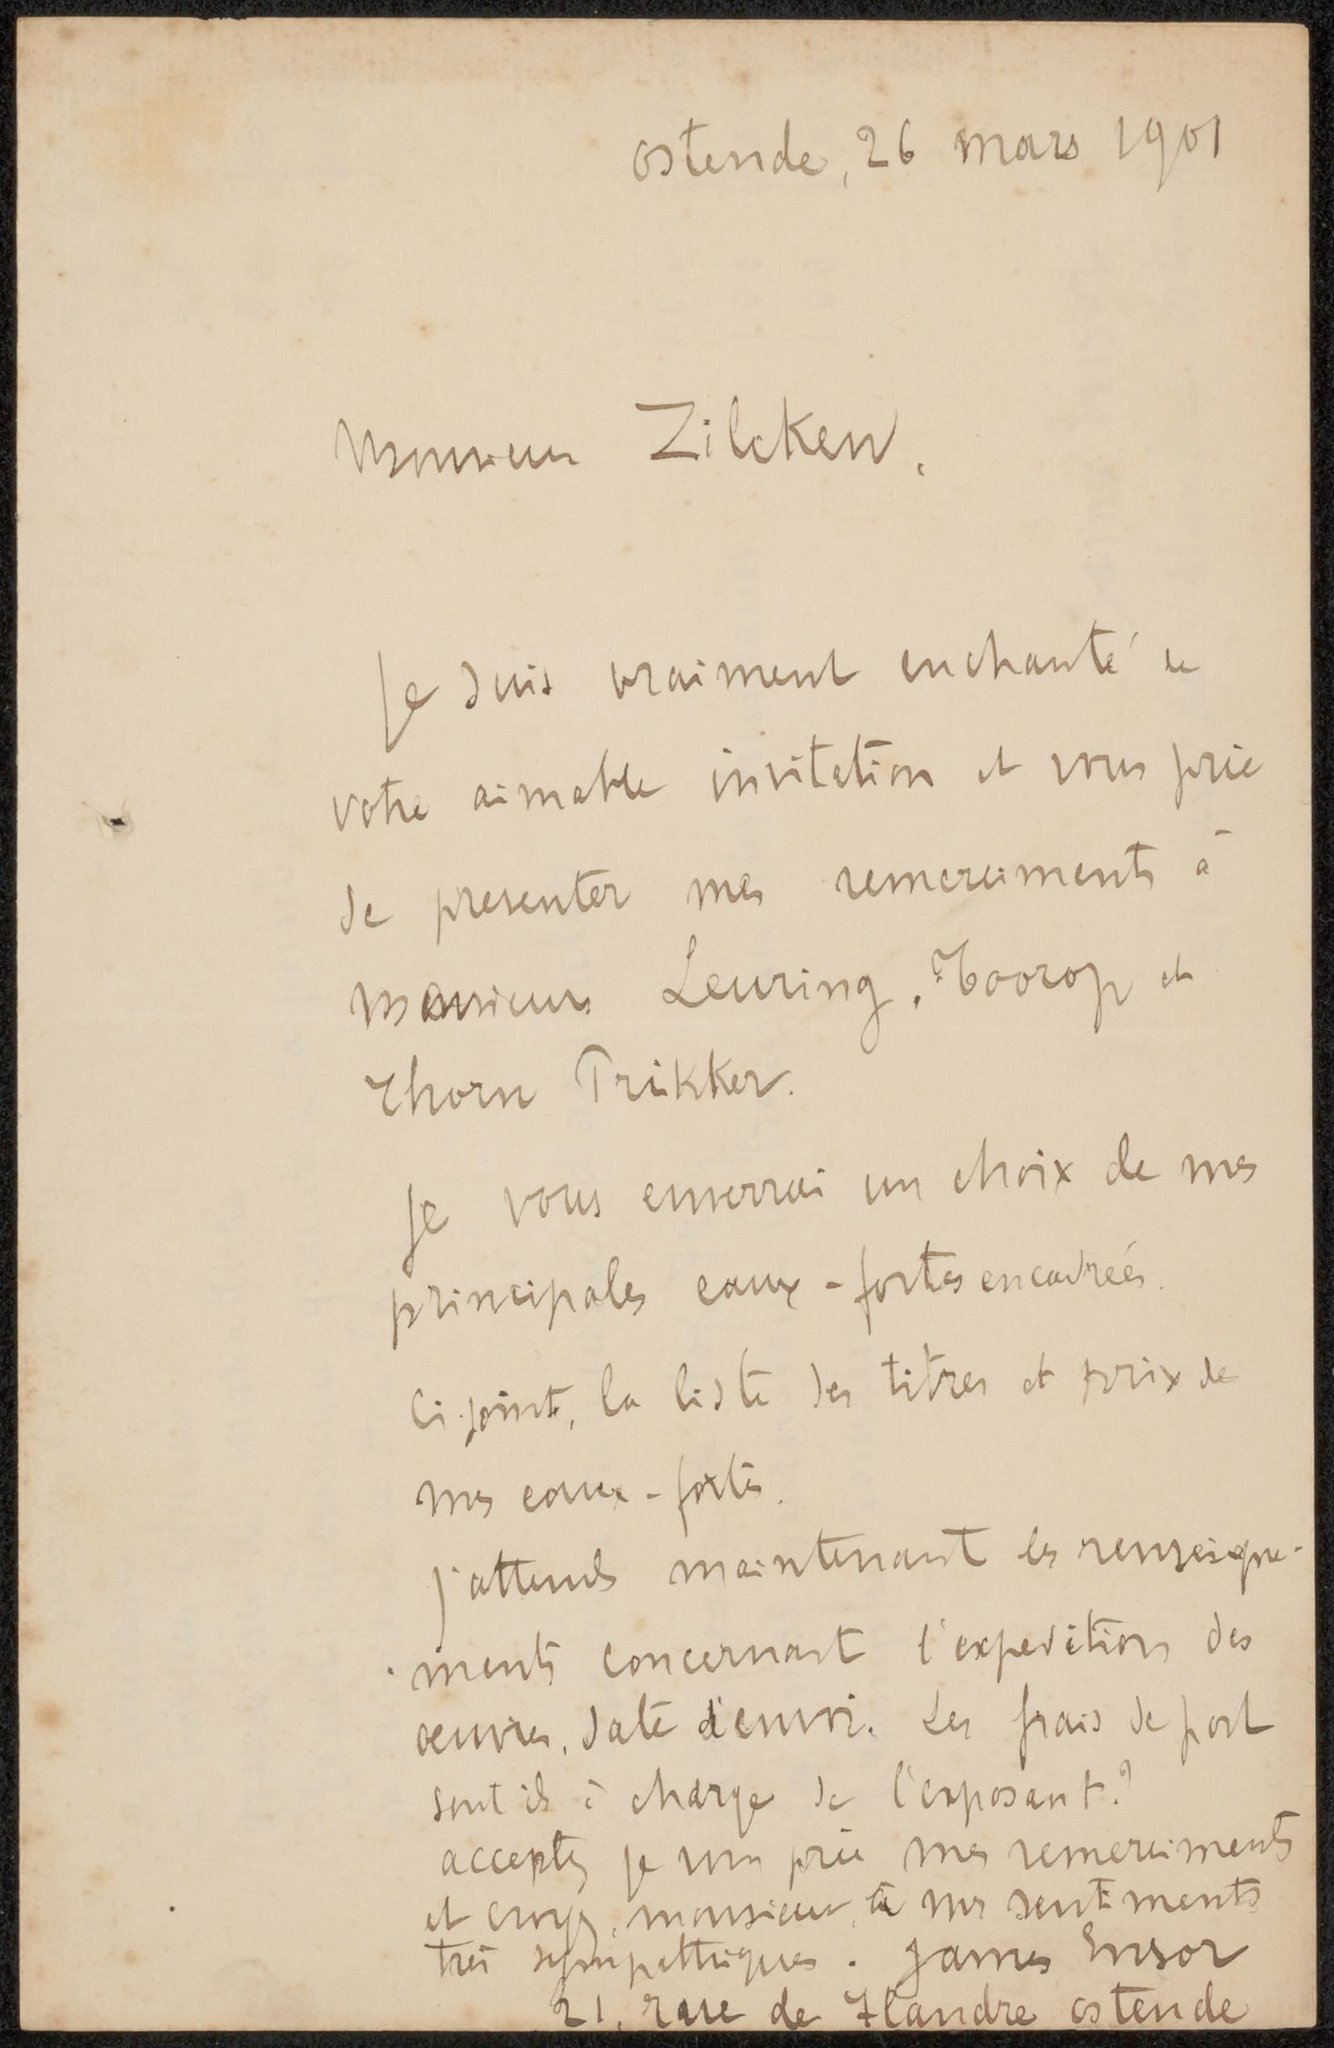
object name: letter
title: Brief aan Philip Zilcken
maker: james ensor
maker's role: print maker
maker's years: 1860-1949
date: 1901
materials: ink, paper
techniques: pen, writing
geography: oostende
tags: the hague, painter, draughtsman, philip zilcken, the graphic arts, temporary exhibition, 'salon', money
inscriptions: watermark, collector's mark: ‘RPK’